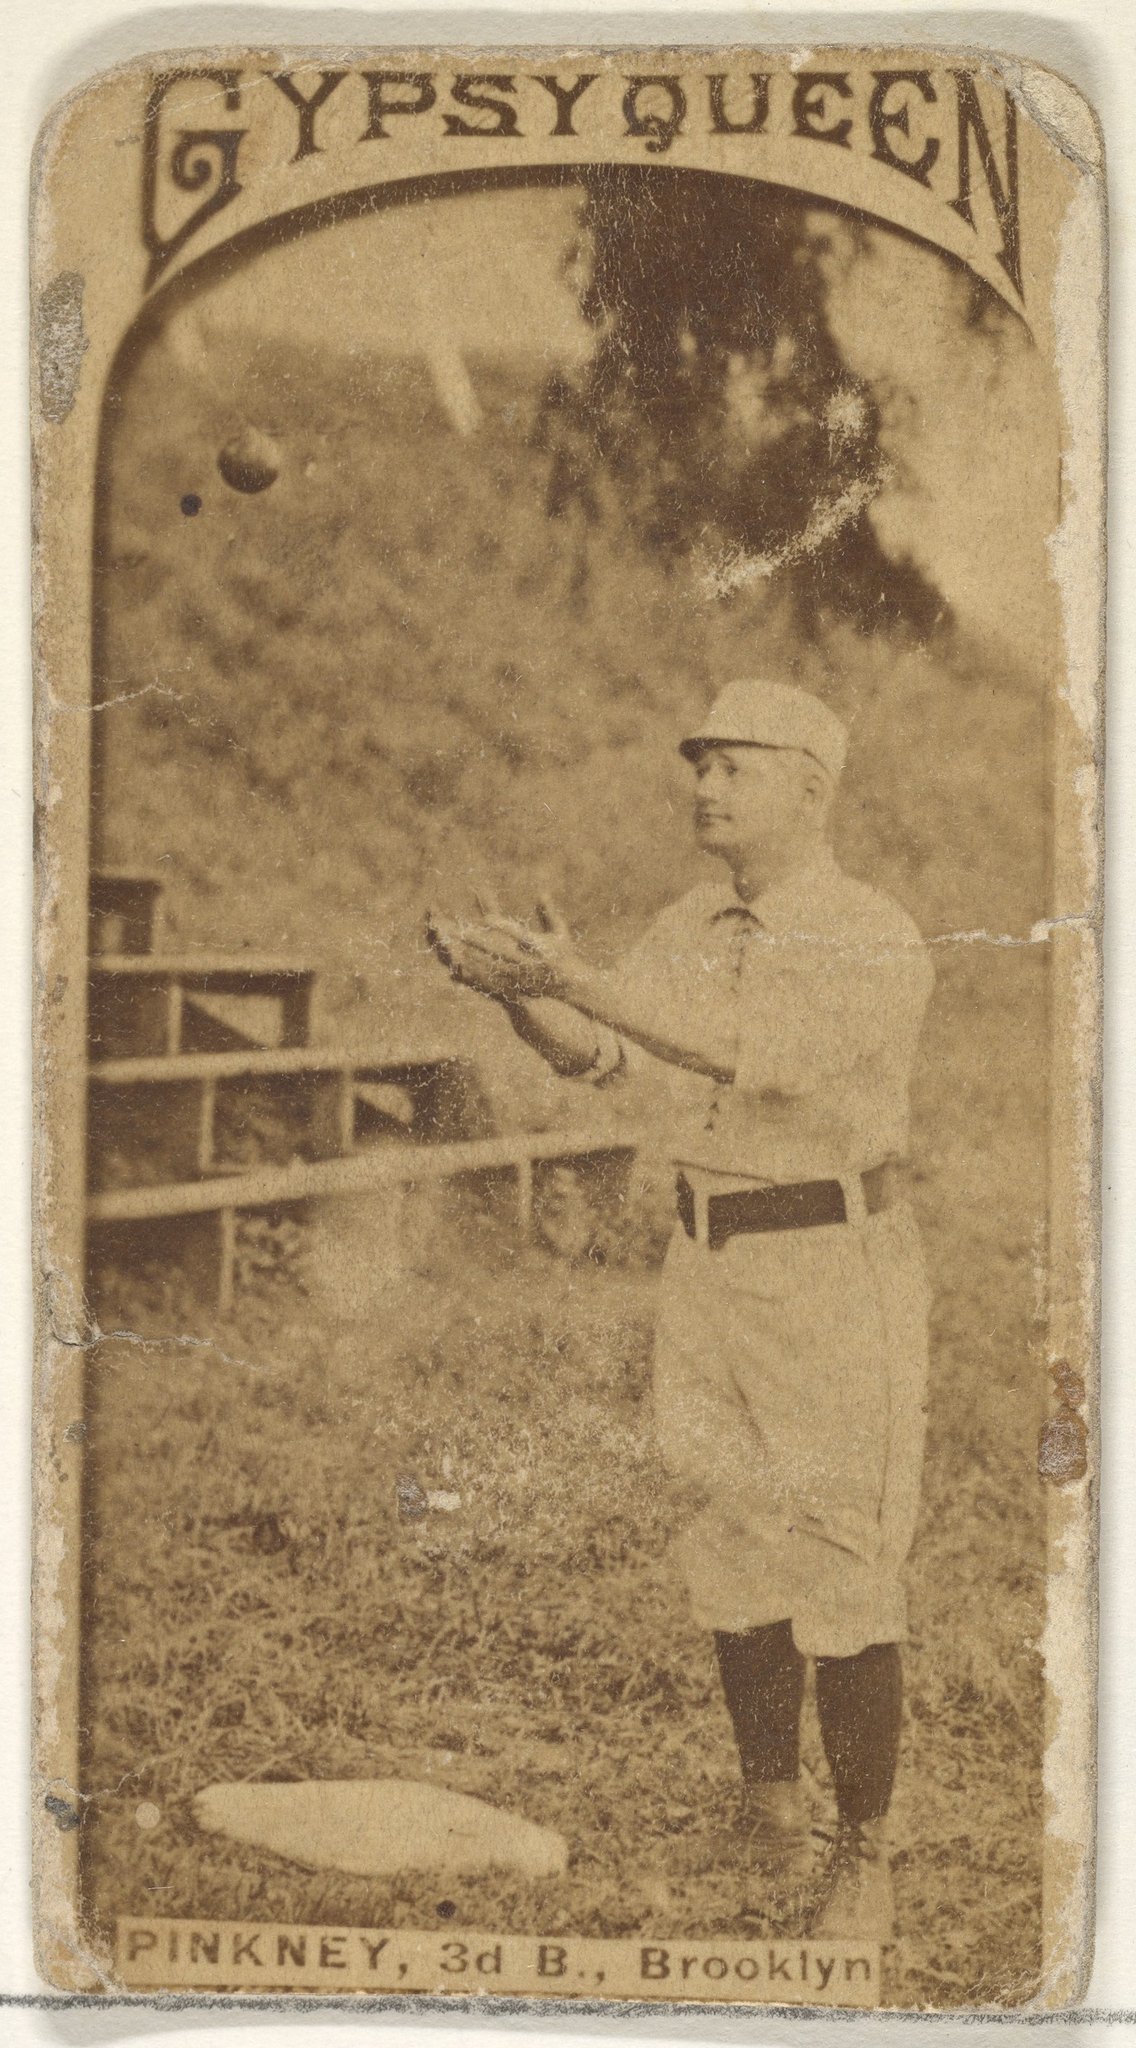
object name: baseball card, photograph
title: Pinkney, 3rd Base, Brooklyn, from the Old Judge series (N172) for Gypsy Queen Cigarettes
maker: goodwin & company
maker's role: publisher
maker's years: 1850-1950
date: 1887-1890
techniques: albumen silver print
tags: men,portraits,baseball,athletes